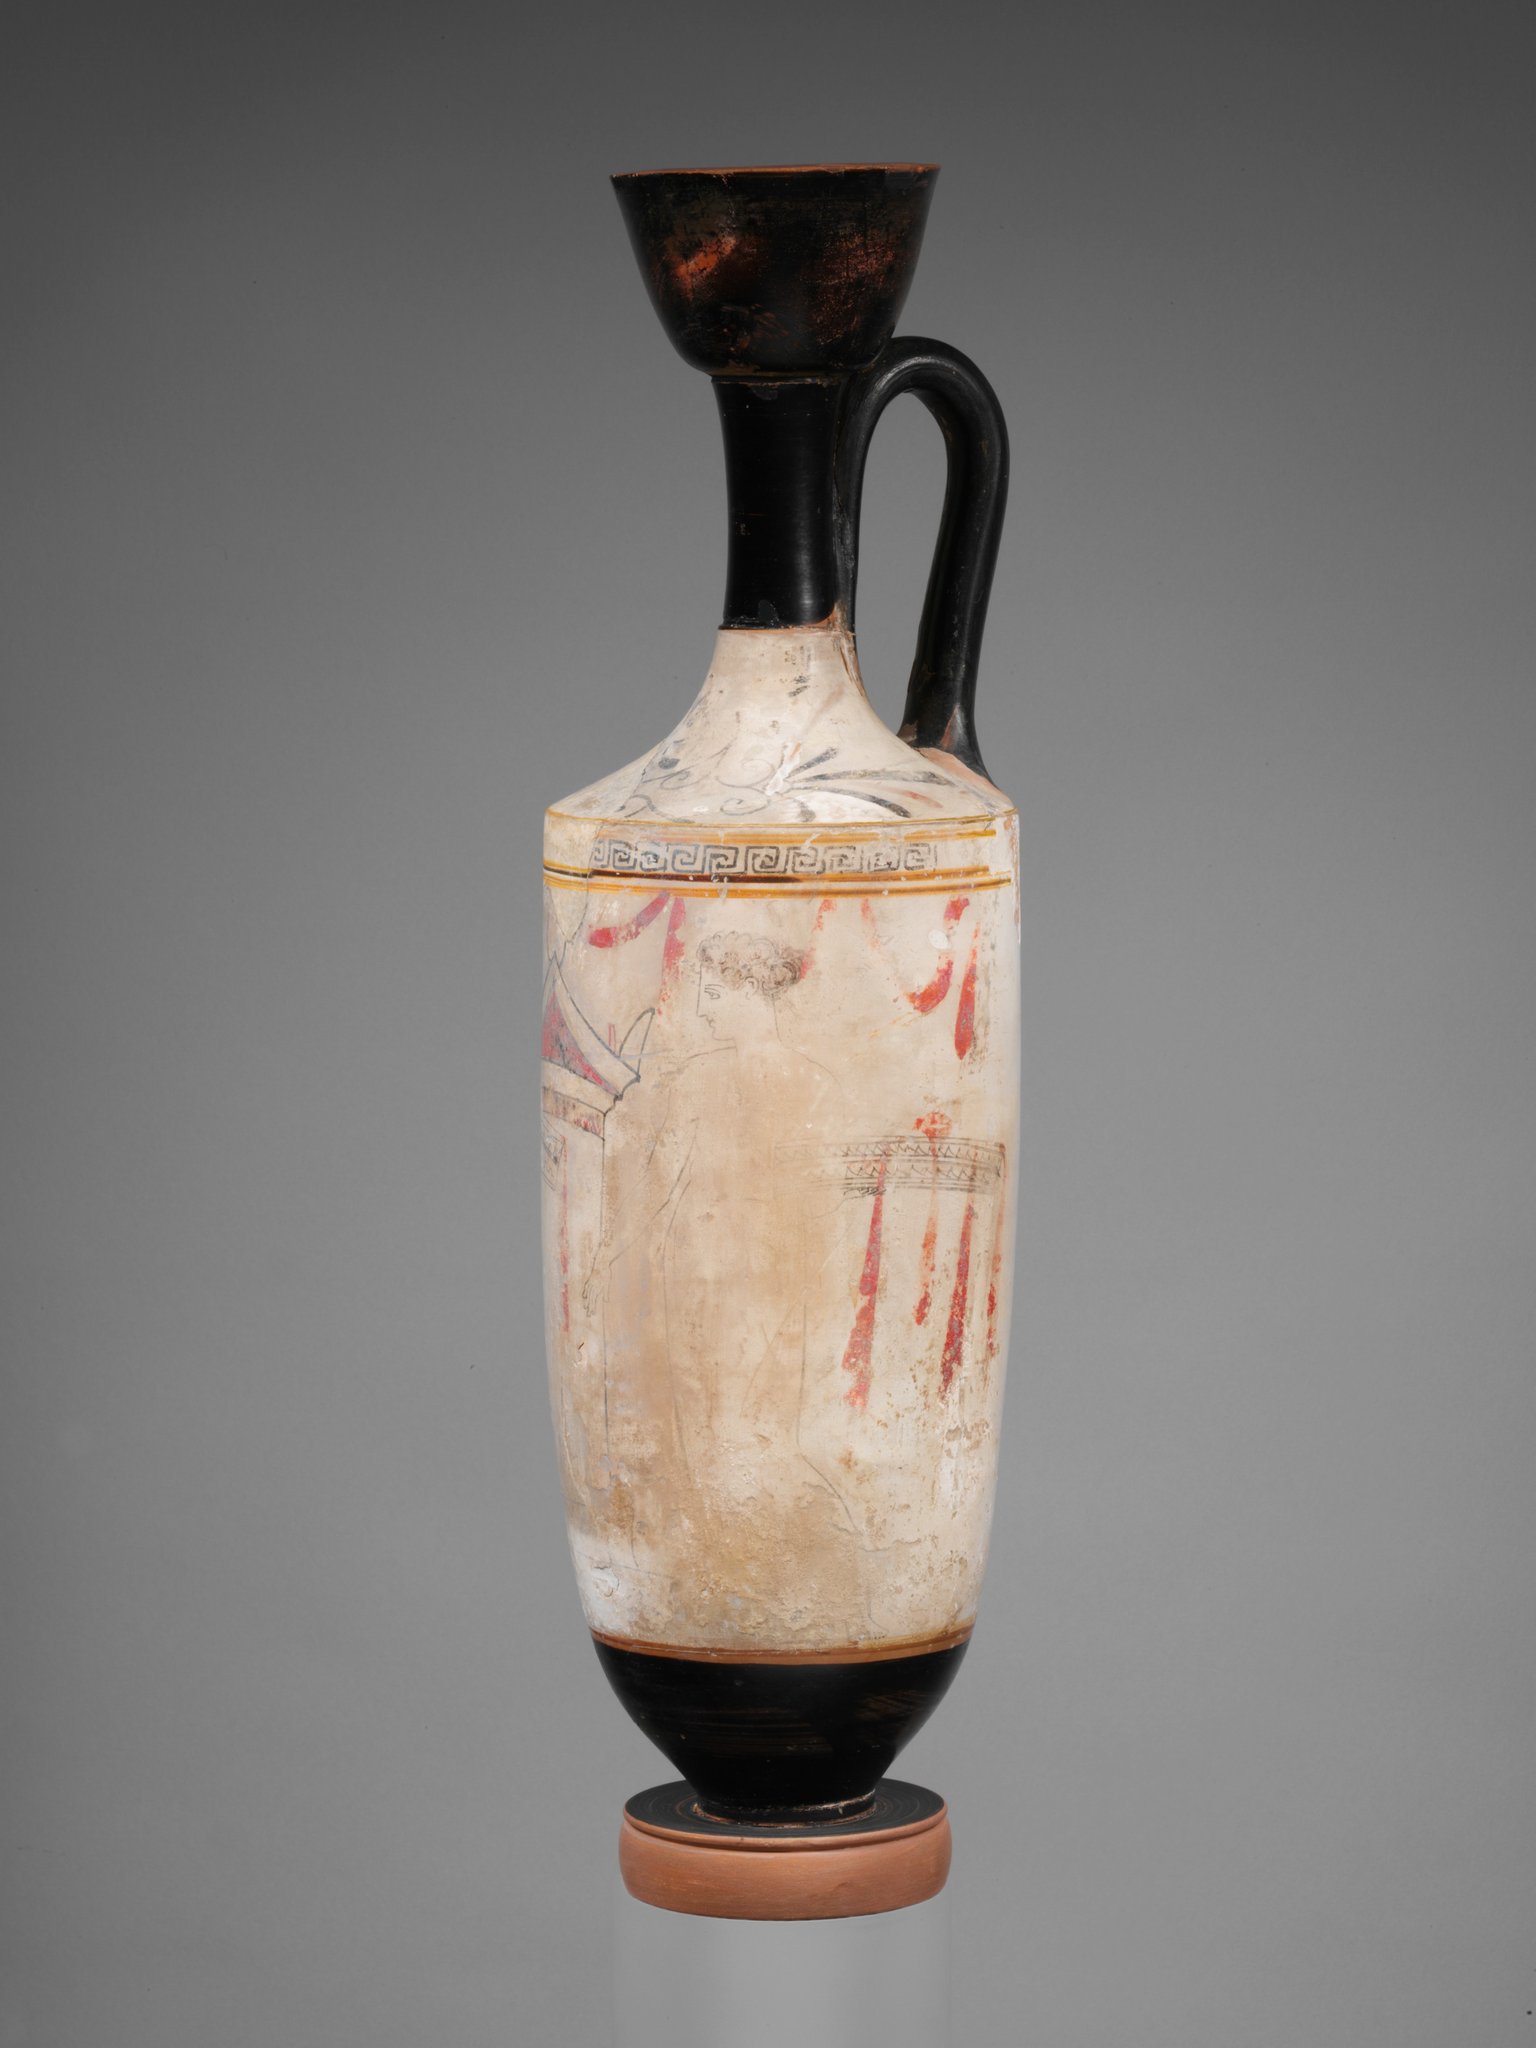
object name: lekythos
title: Terracotta lekythos (oil flask)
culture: greek, attic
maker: painter of berlin 2464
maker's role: artist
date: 420-410 BCE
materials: terracotta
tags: women